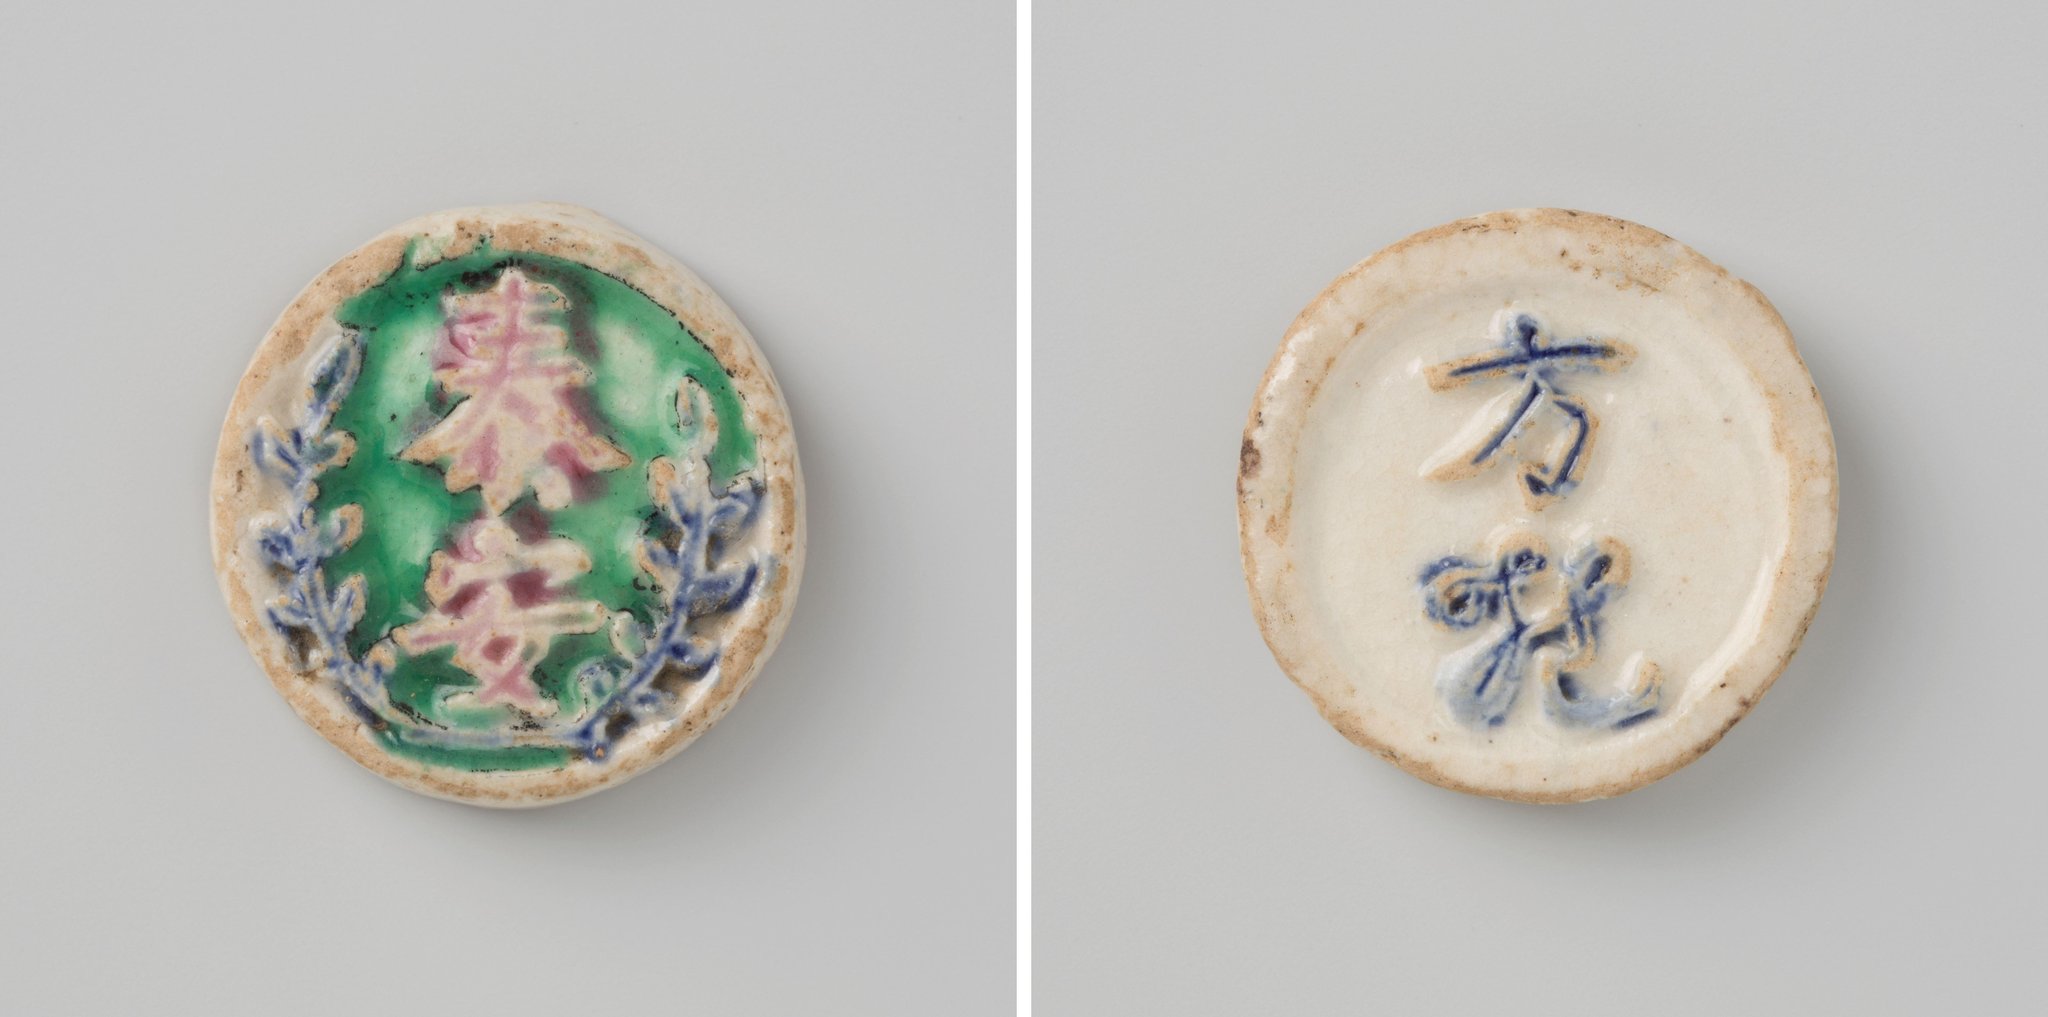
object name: coin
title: Speelhuispenning uit Thailand ter waarde van een fuang, 1760-1871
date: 1760-1871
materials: porcelain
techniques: firing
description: Ronde porseleinen speelhuispenning, die ook als munt is gebruikt. Voorzijde: tussen twee takken twee Chinese karakters. Keerzijde: twee Chinese karakters.